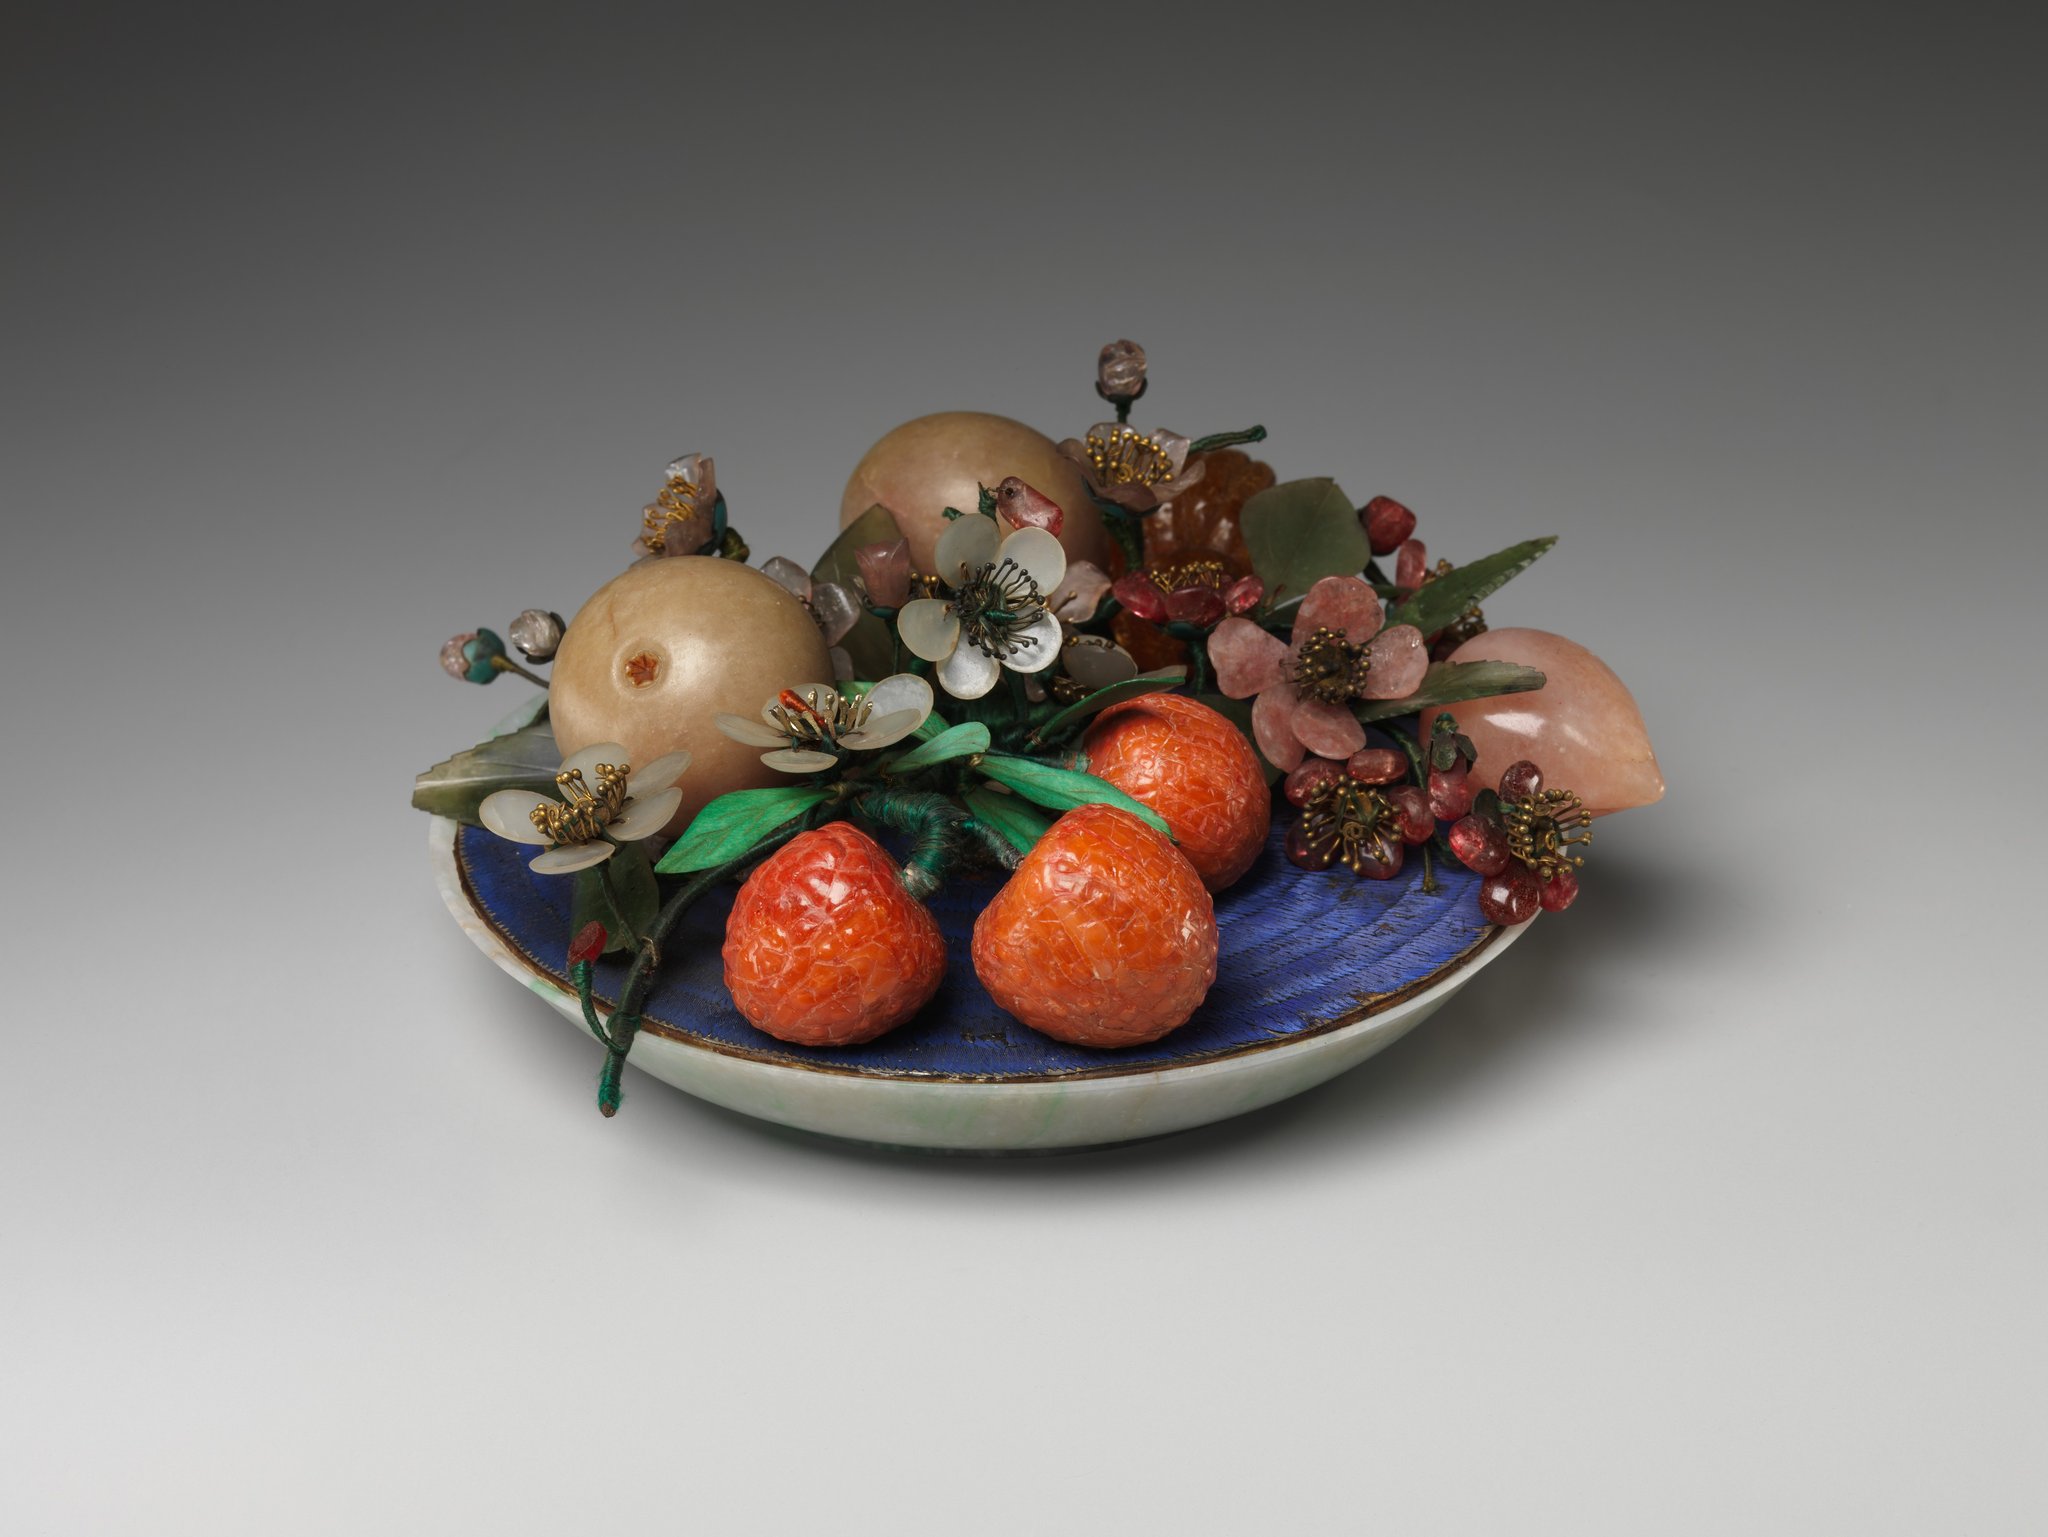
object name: dish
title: Dish of Fruit and Peach Blossoms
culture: chinese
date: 1701-1900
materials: amber, bone, feather, glass, jade, stone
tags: fruit,peaches,flowers